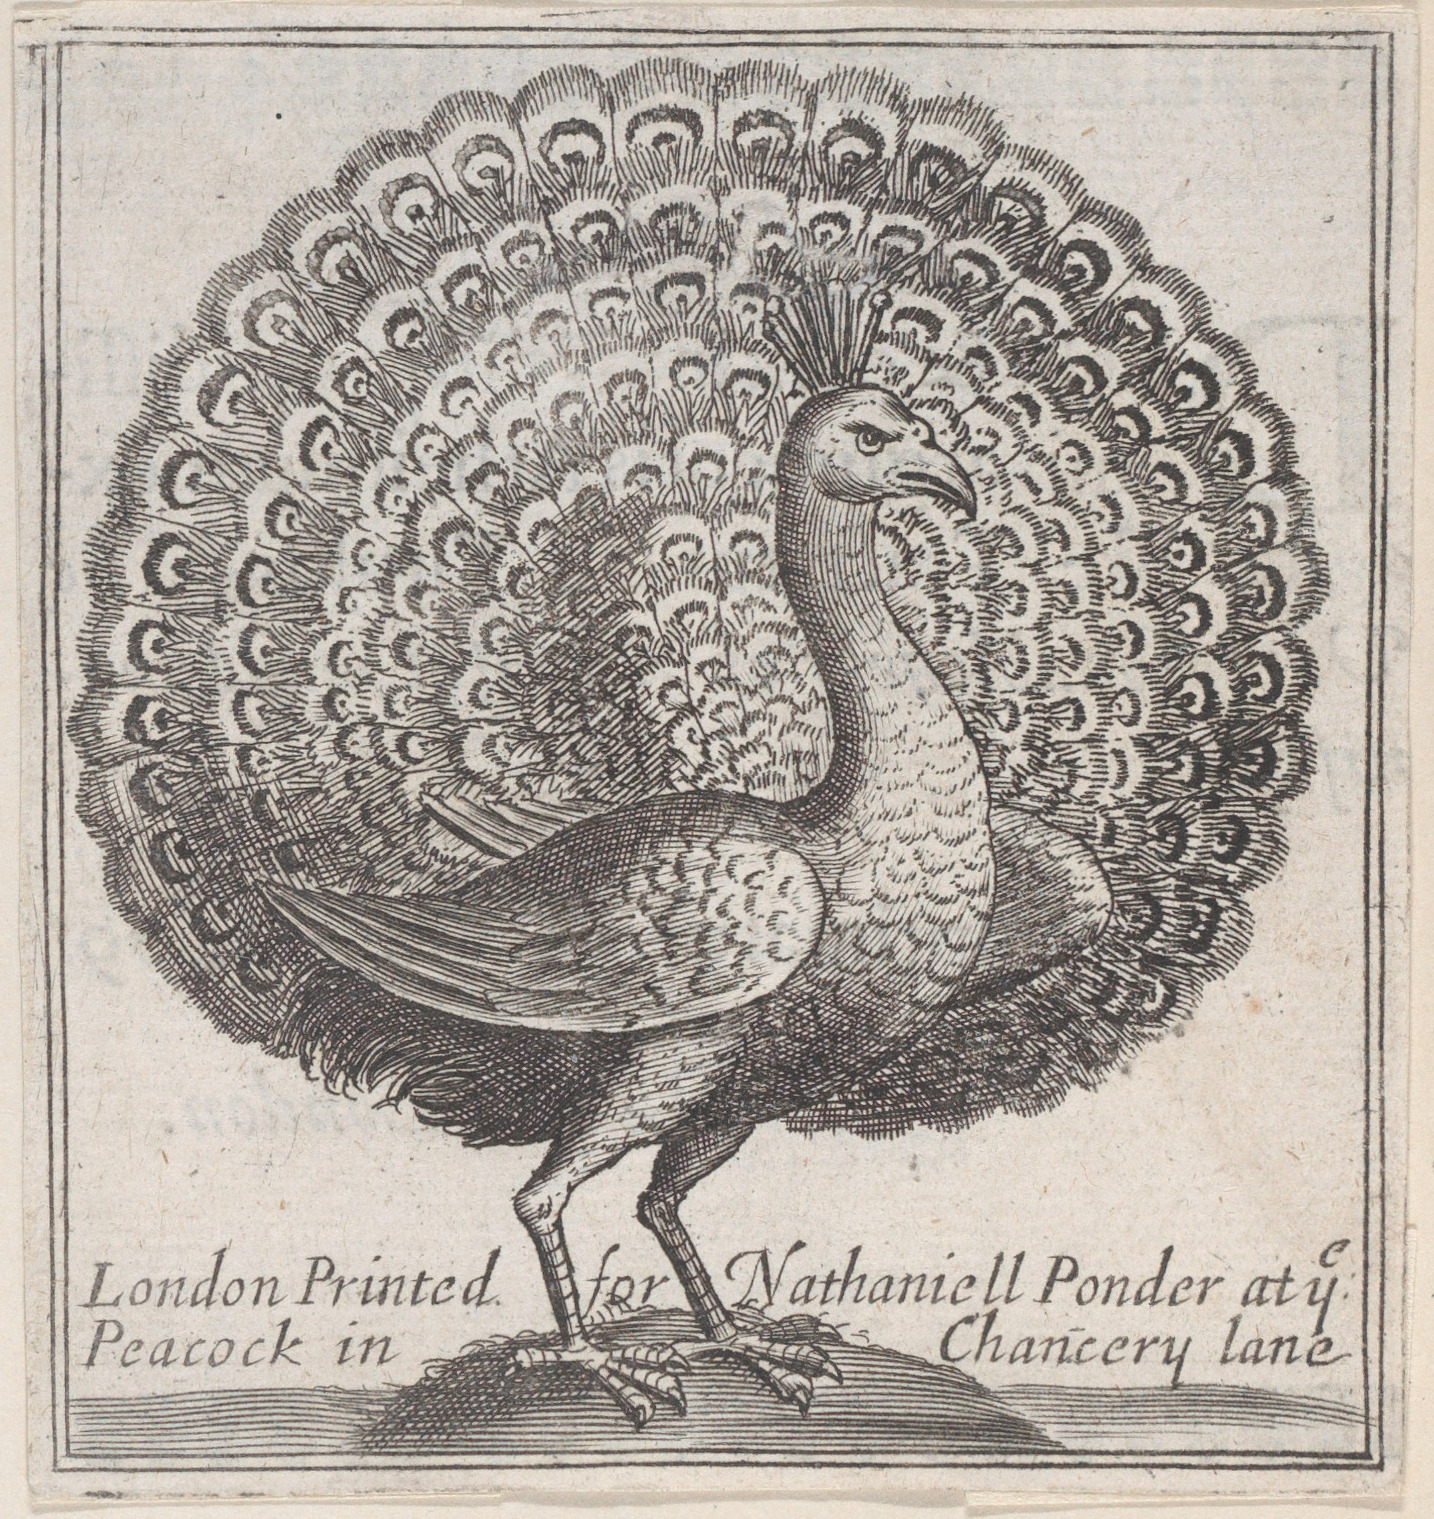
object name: print, trade card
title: Trade Card for Nathaniell Ponder, Bookseller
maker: anonymous, british, 18th century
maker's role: artist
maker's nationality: british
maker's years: 1700-1800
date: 1701-1800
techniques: engraving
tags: peacocks